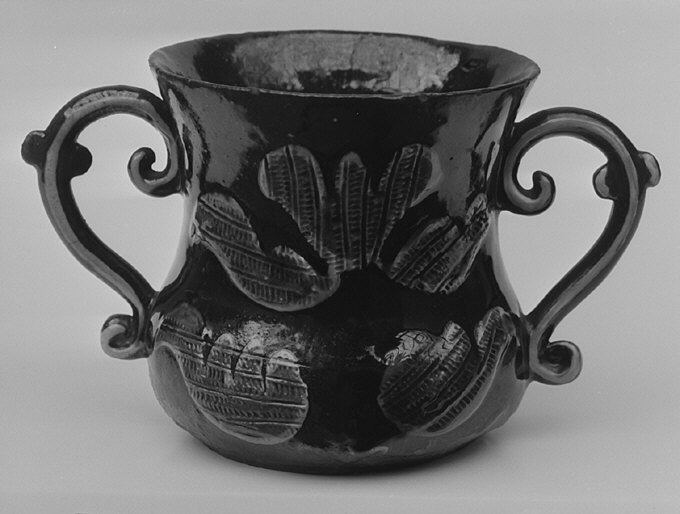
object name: cup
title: Two-handled cup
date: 1667-1733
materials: earthenware